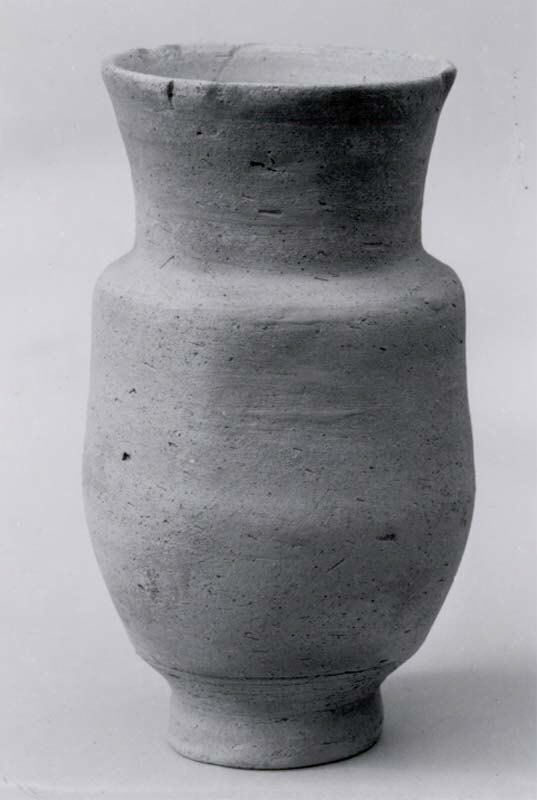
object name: jar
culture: elamite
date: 2000 BCE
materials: ceramic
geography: iran